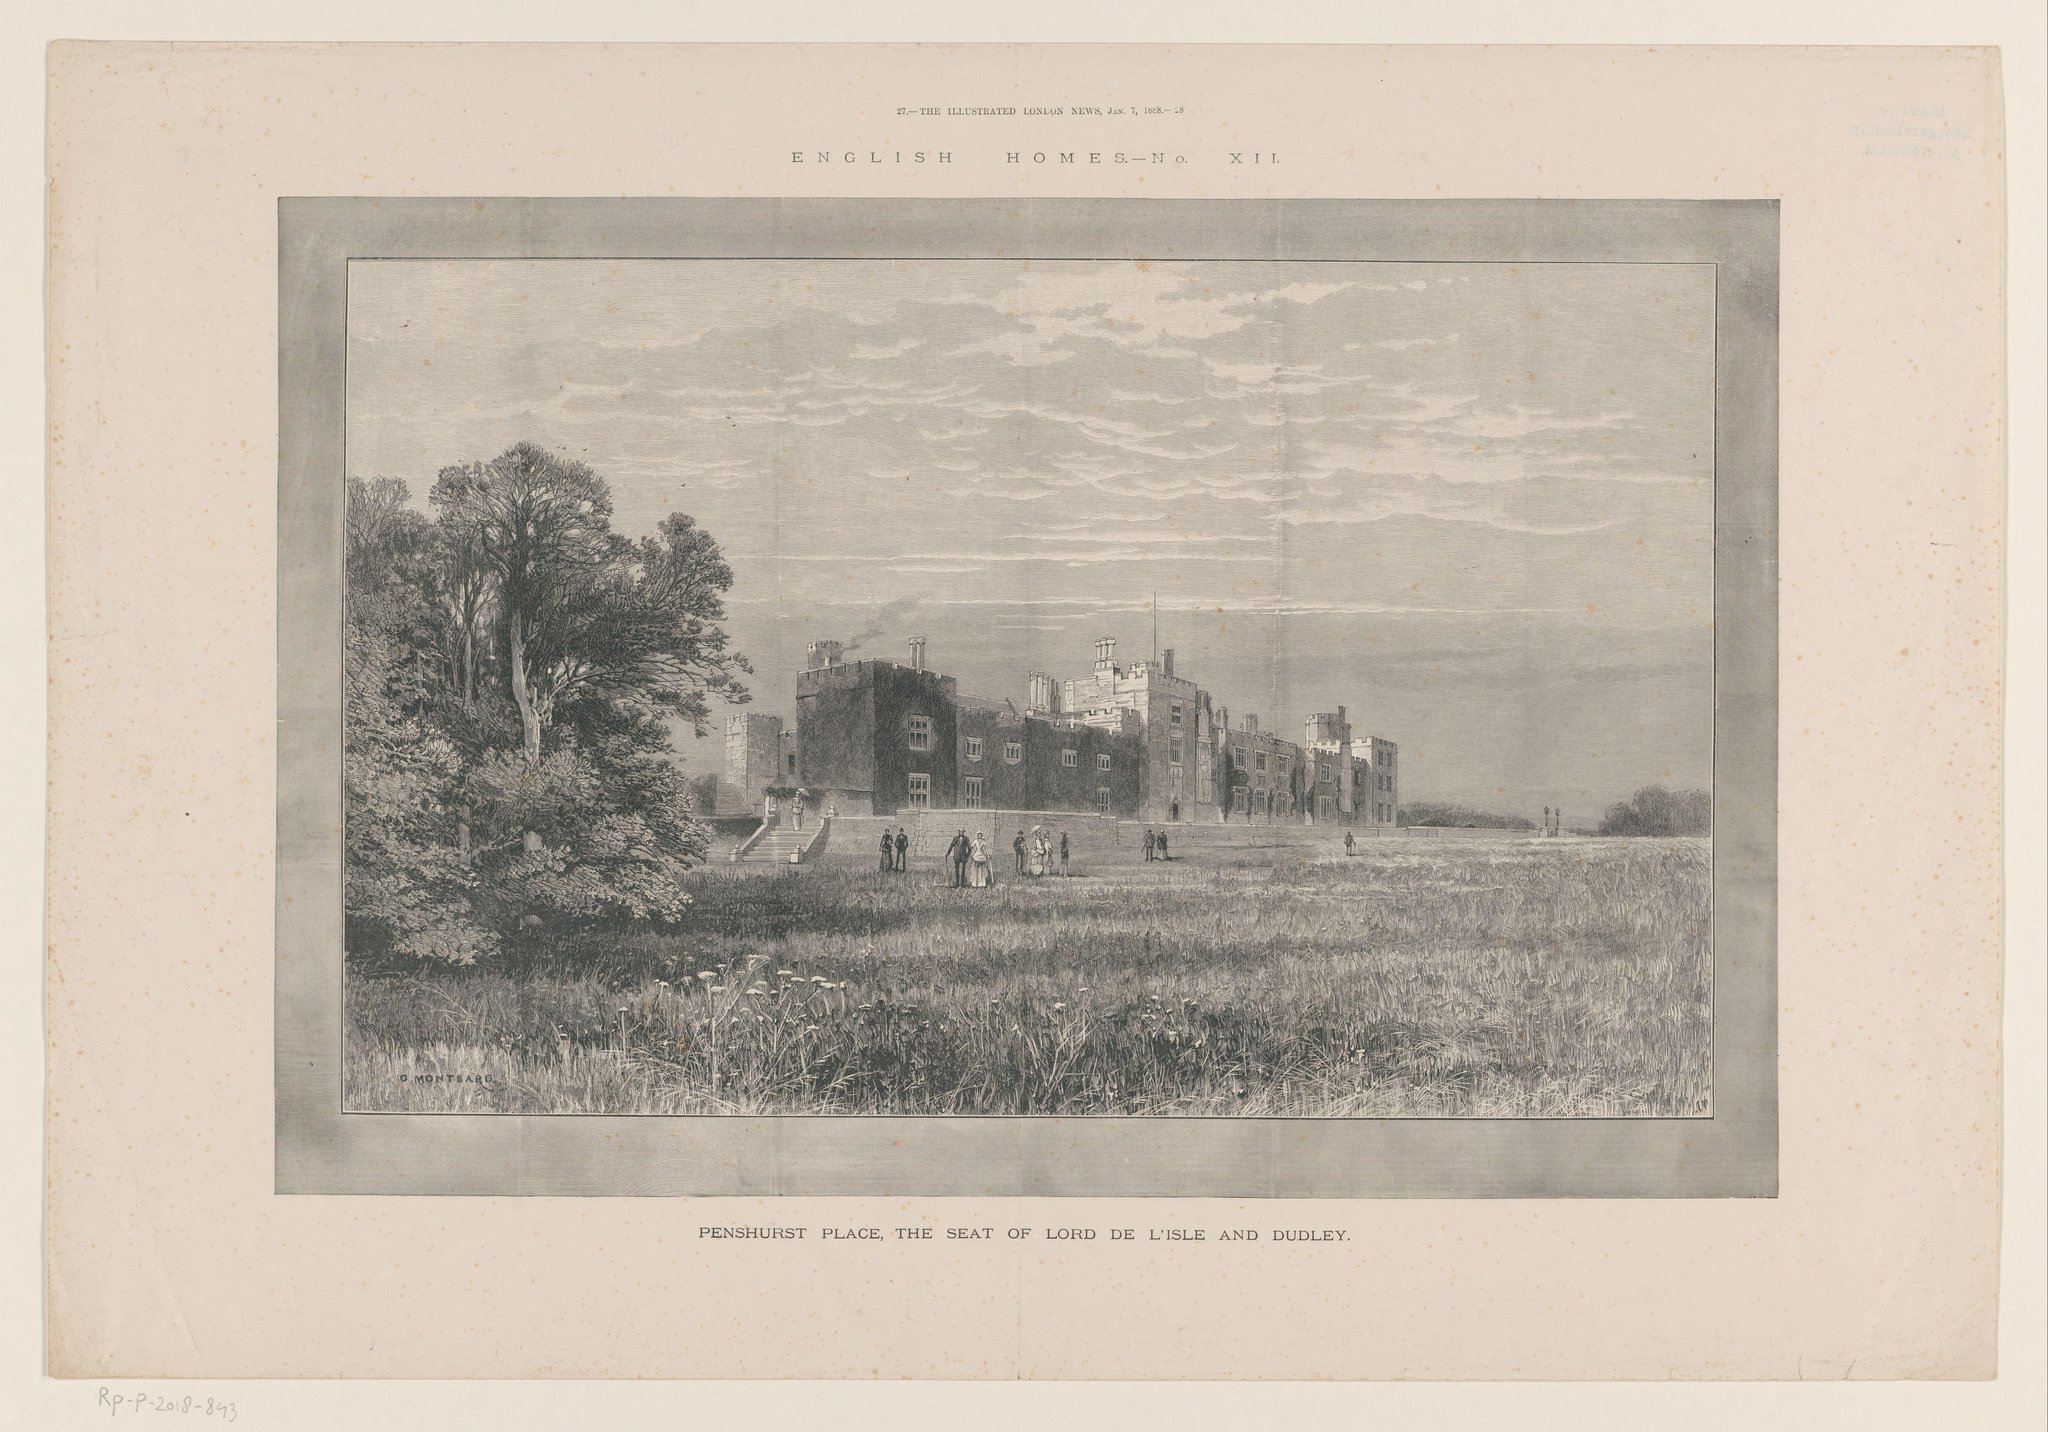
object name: print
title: Gezicht op Penshurst Place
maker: charles auguste loye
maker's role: print maker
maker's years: 1841-1905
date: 1888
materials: paper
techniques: engraving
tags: castle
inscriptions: collector's mark: ‘Marine Leesgezelschap Amsterdam’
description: Prent gebruikt in: The Illustrated London News, 7 juni, 1888.